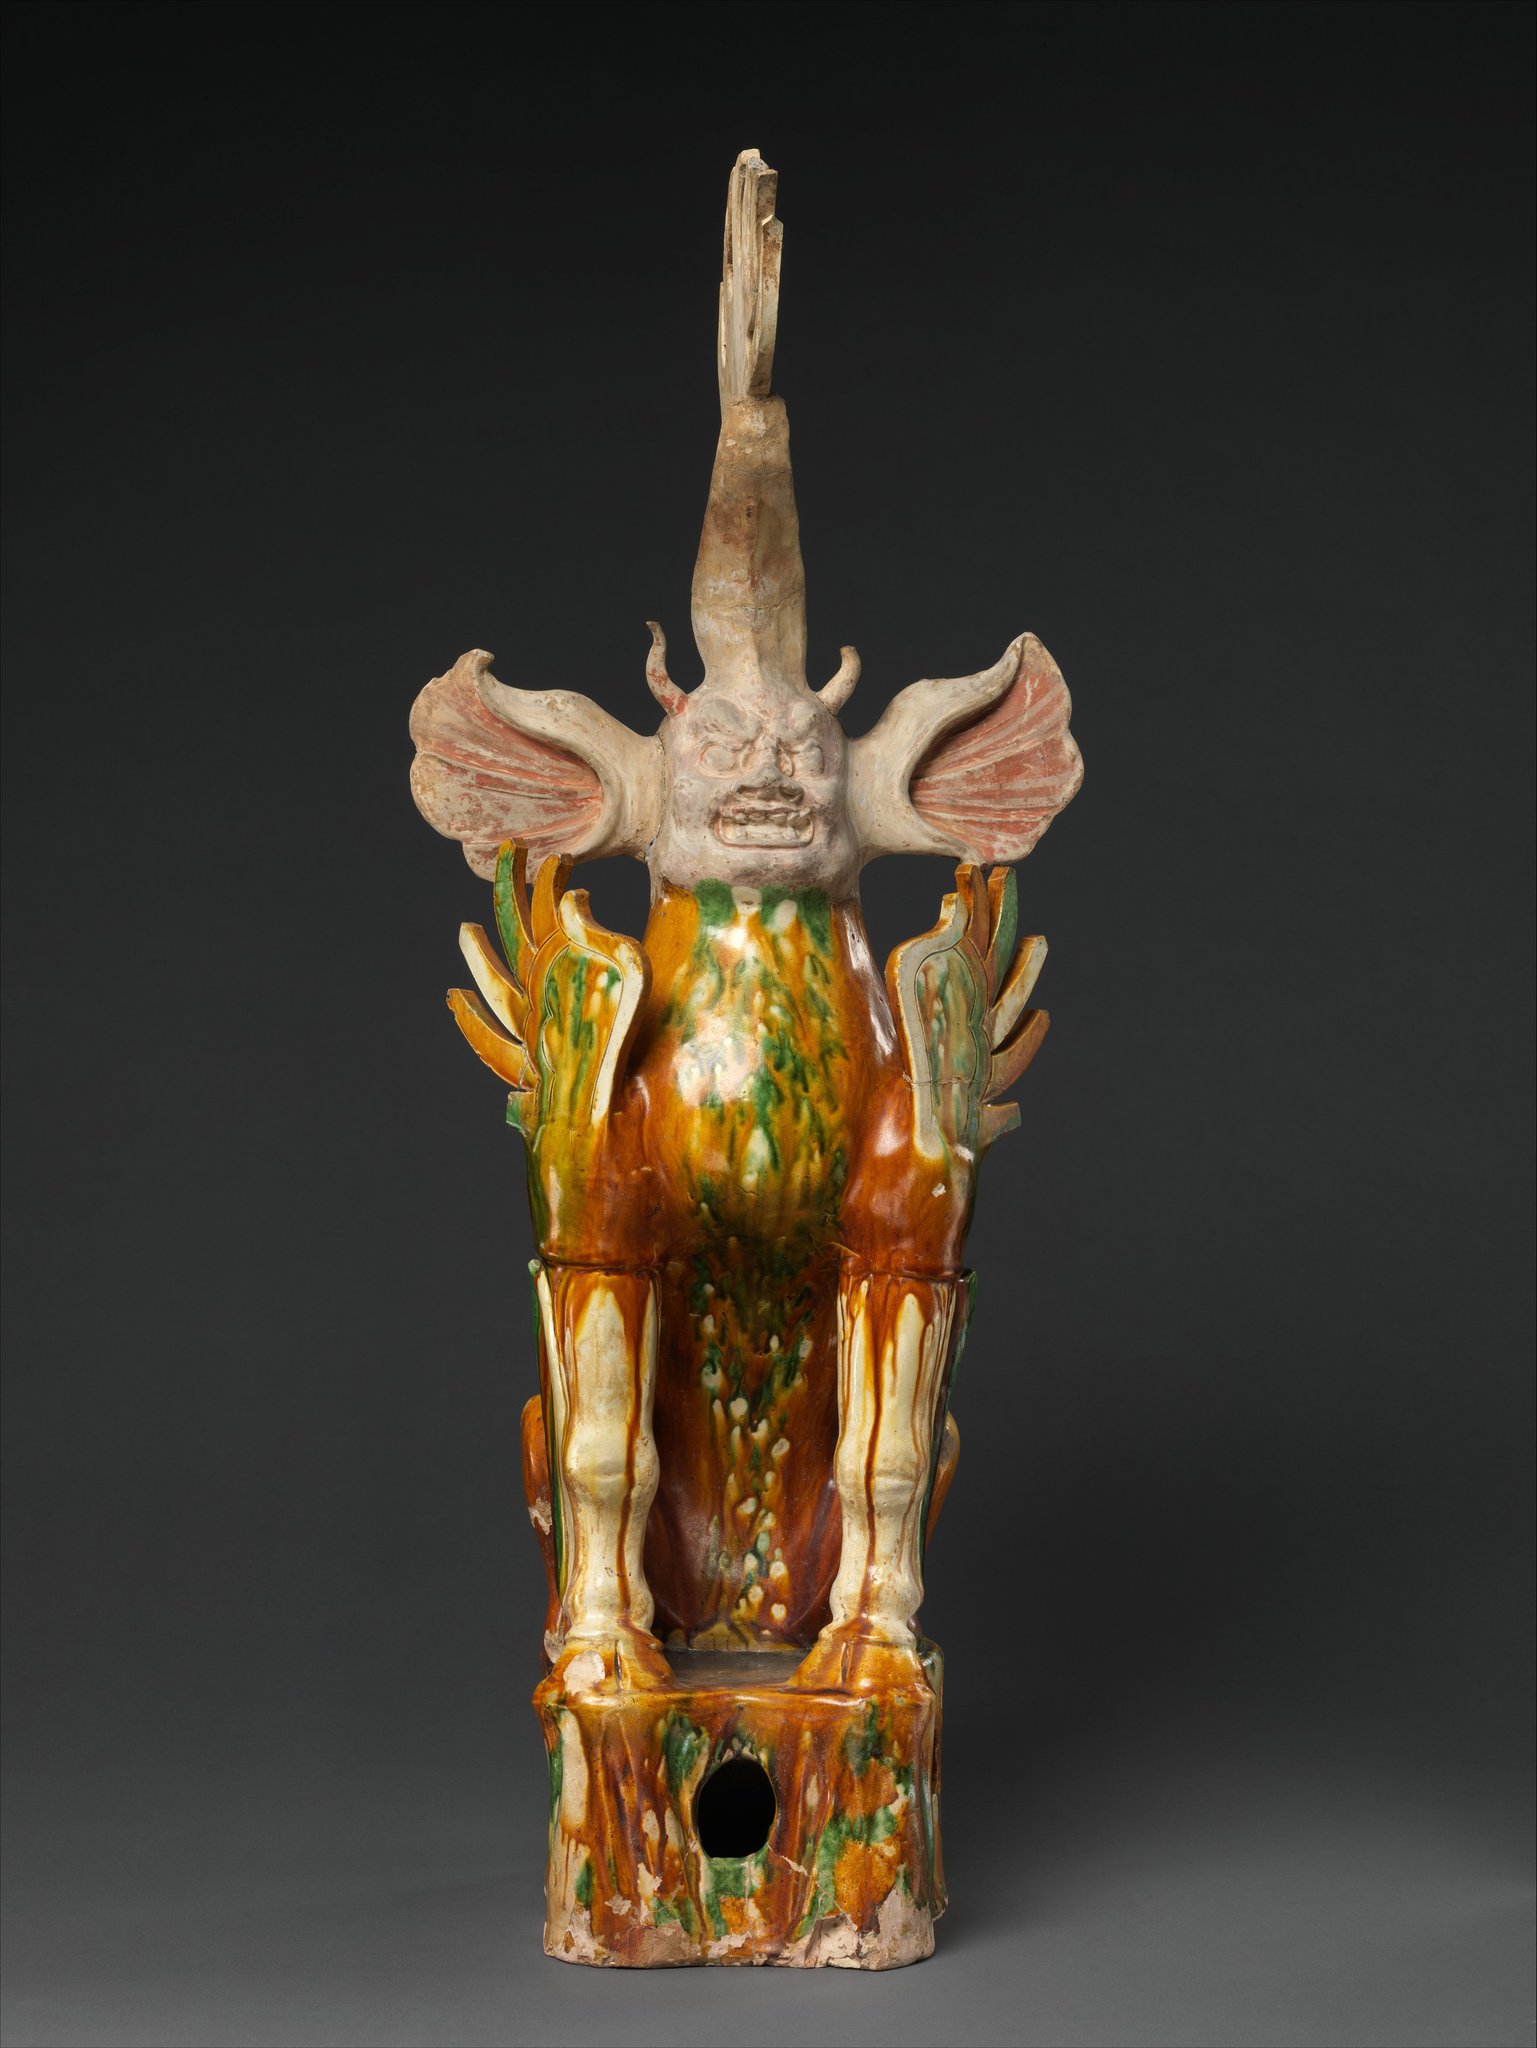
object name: figure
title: Tomb guardian beast (Zhenmushou)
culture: chinese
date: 667-700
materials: earthenware, glaze, pigment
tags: mythical creatures